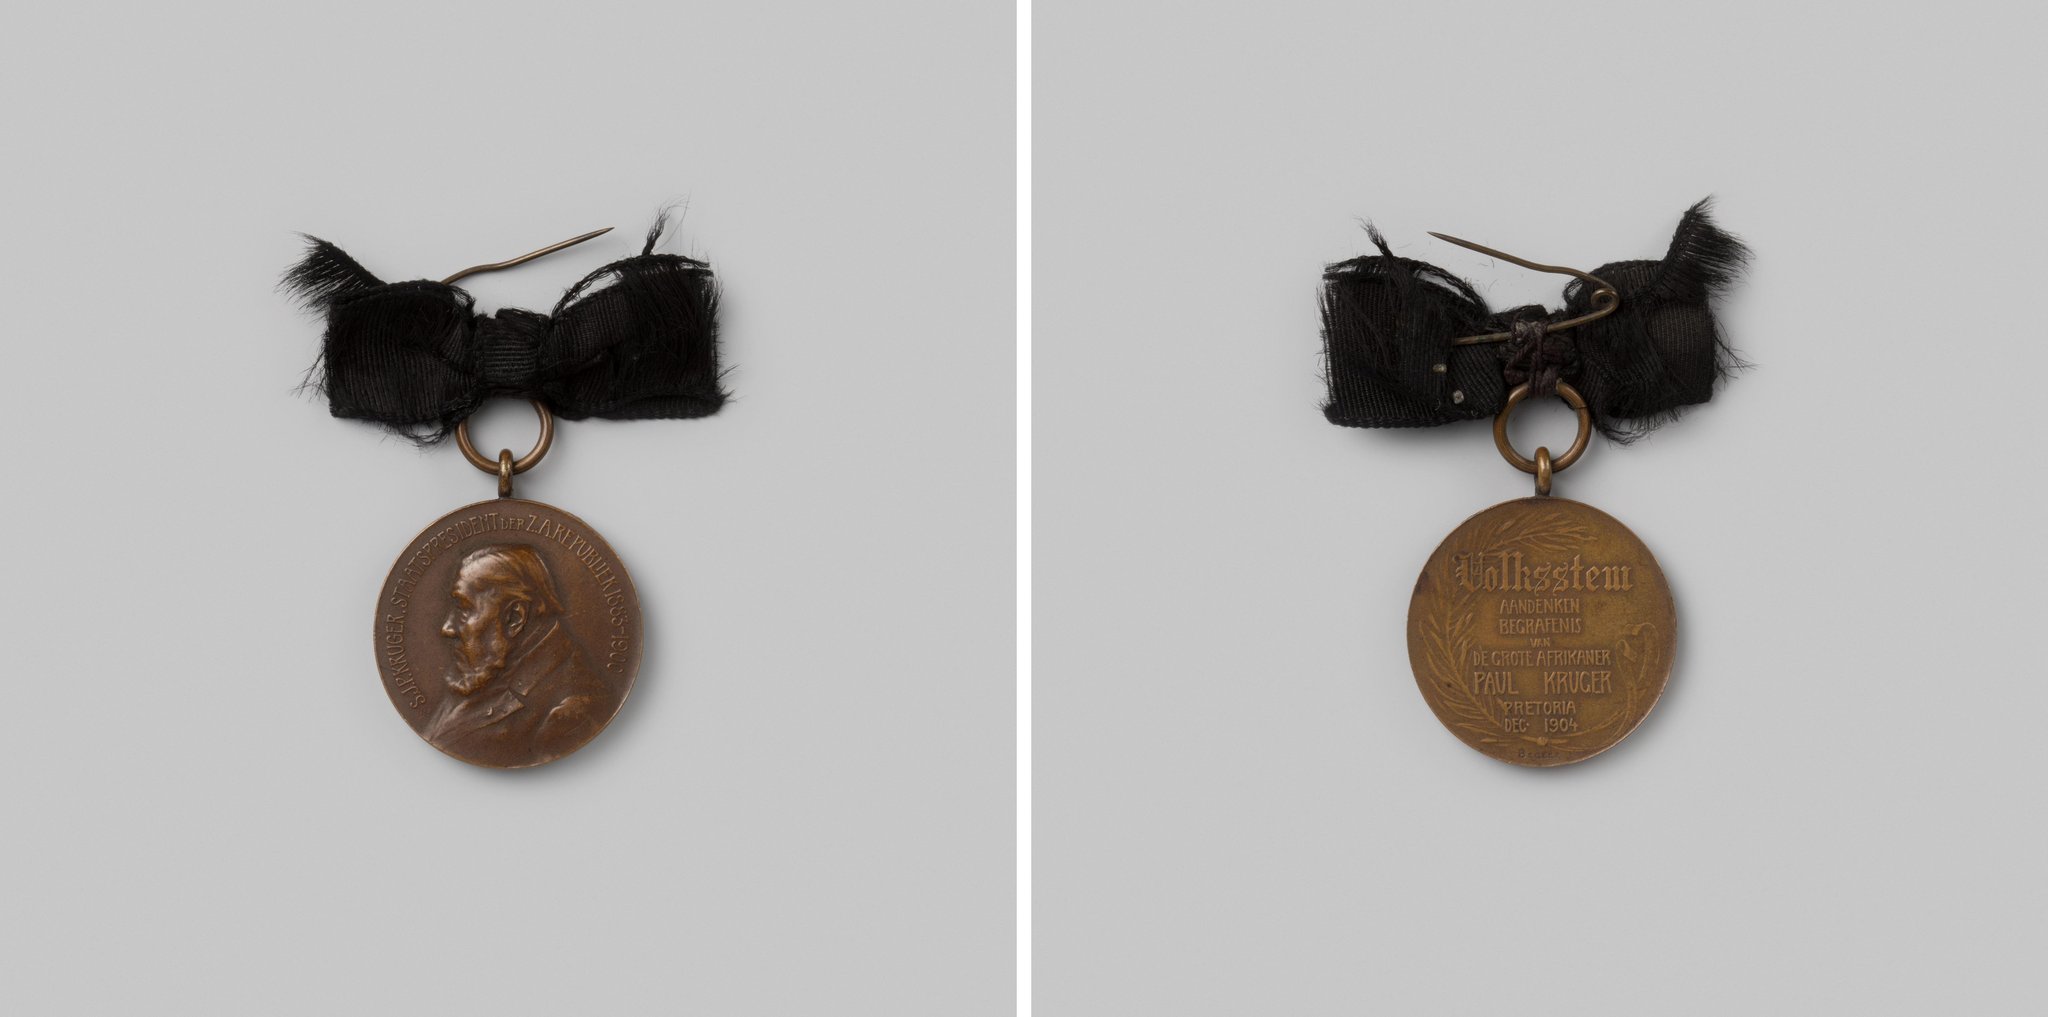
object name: history medal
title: Begrafenis van Paul Kruger, president van de republiek Zuid-Afrika, te Pretoria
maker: johannes cornelis wienecke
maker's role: medailleur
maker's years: 1872-1945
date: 1904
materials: bronze, textile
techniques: striking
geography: utrecht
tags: vaalbank, clarens (zuid-afrika), president, paul kruger, zuid-afrika, pretoria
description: Bronzen penning met draagoog, draagring en zwart, gestrikt lintje. Voorzijde: borststuk man binnen omschrift. Keerzijde: opschrift, omgeven door palmtak.